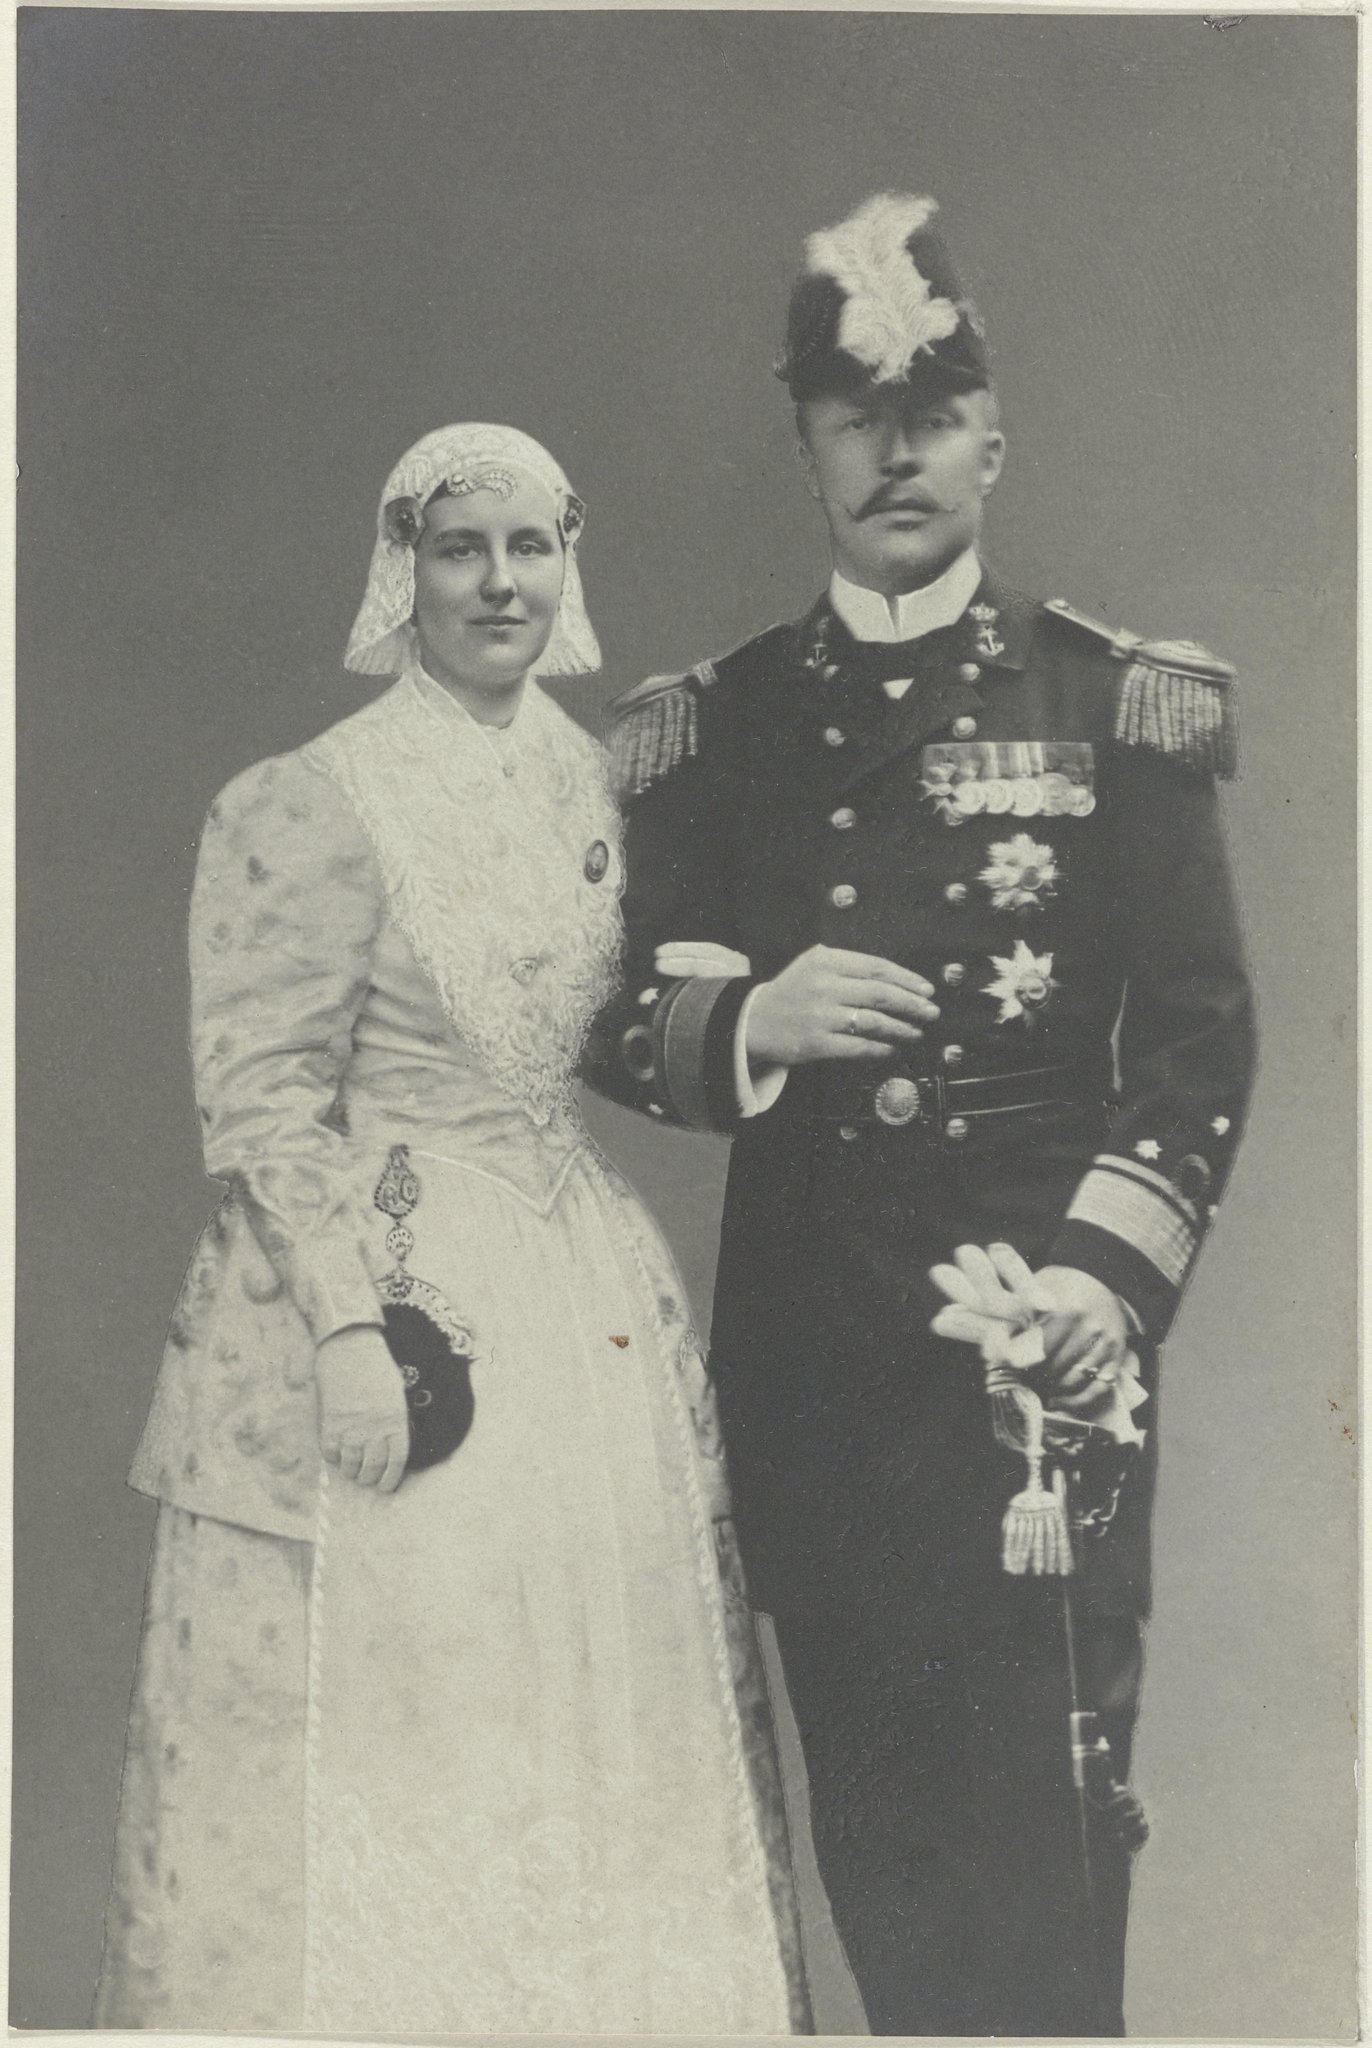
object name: photograph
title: Portret van Wilhelmina, koningin der Nederlanden, en Hendrik van Mecklenburg-Schwerin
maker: idanus hendrikus slaterus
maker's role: fotograaf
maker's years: 1846-1921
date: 1905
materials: photographic support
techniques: gelatin silver print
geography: leeuwarden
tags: print maker, wilhelmina of the netherlands, the hague, hendrik (prins der nederlanden (1876-1934))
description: De hier vermelde titel verwijst naar de hoogst verkregen titel van de geportretteerde, niet per se naar de titel die de geportretteerde op deze voorstelling draagt.